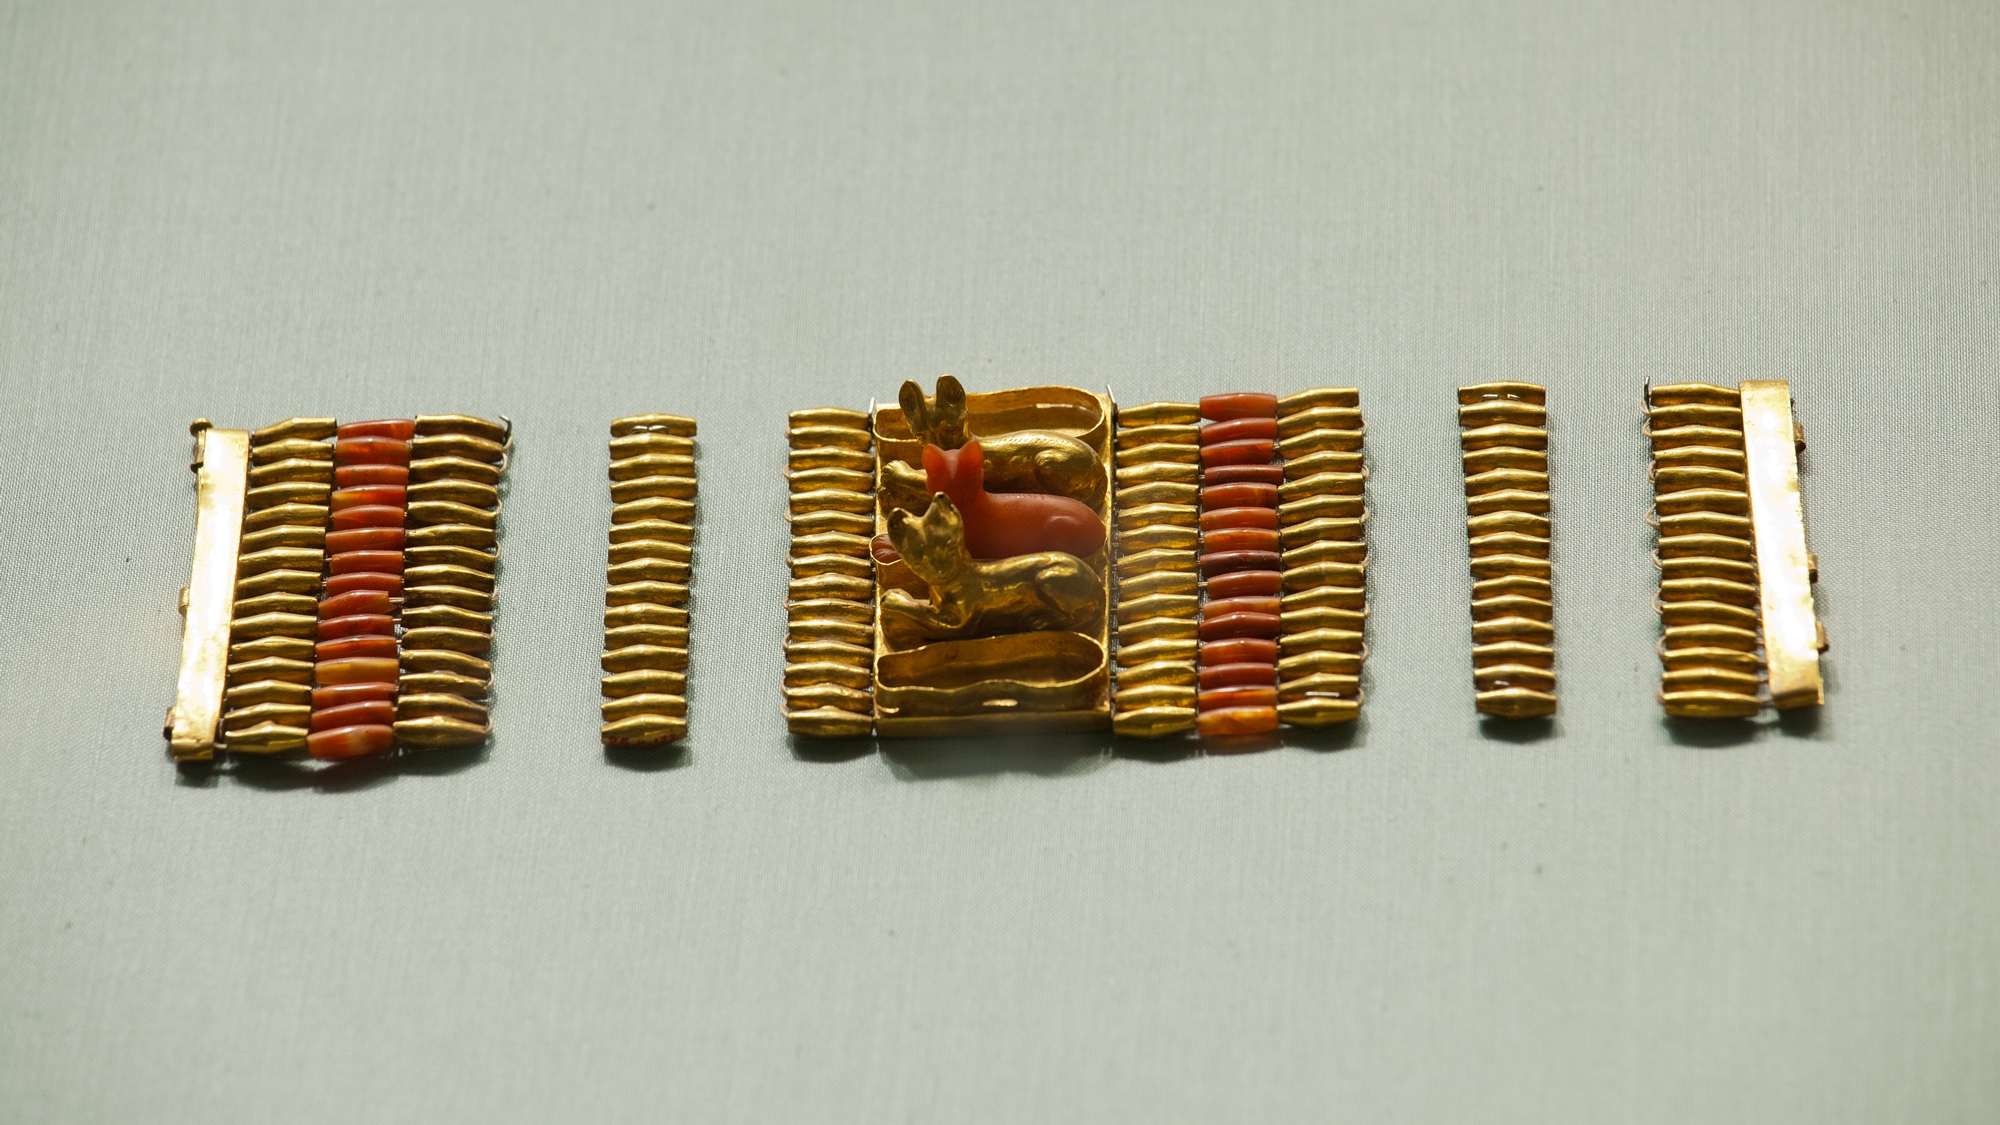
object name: bracelet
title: Cuff Bracelet with Cat Amulets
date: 1479-1425 BCE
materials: gemstone, glass, gold, lapis lazuli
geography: egypt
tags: cats